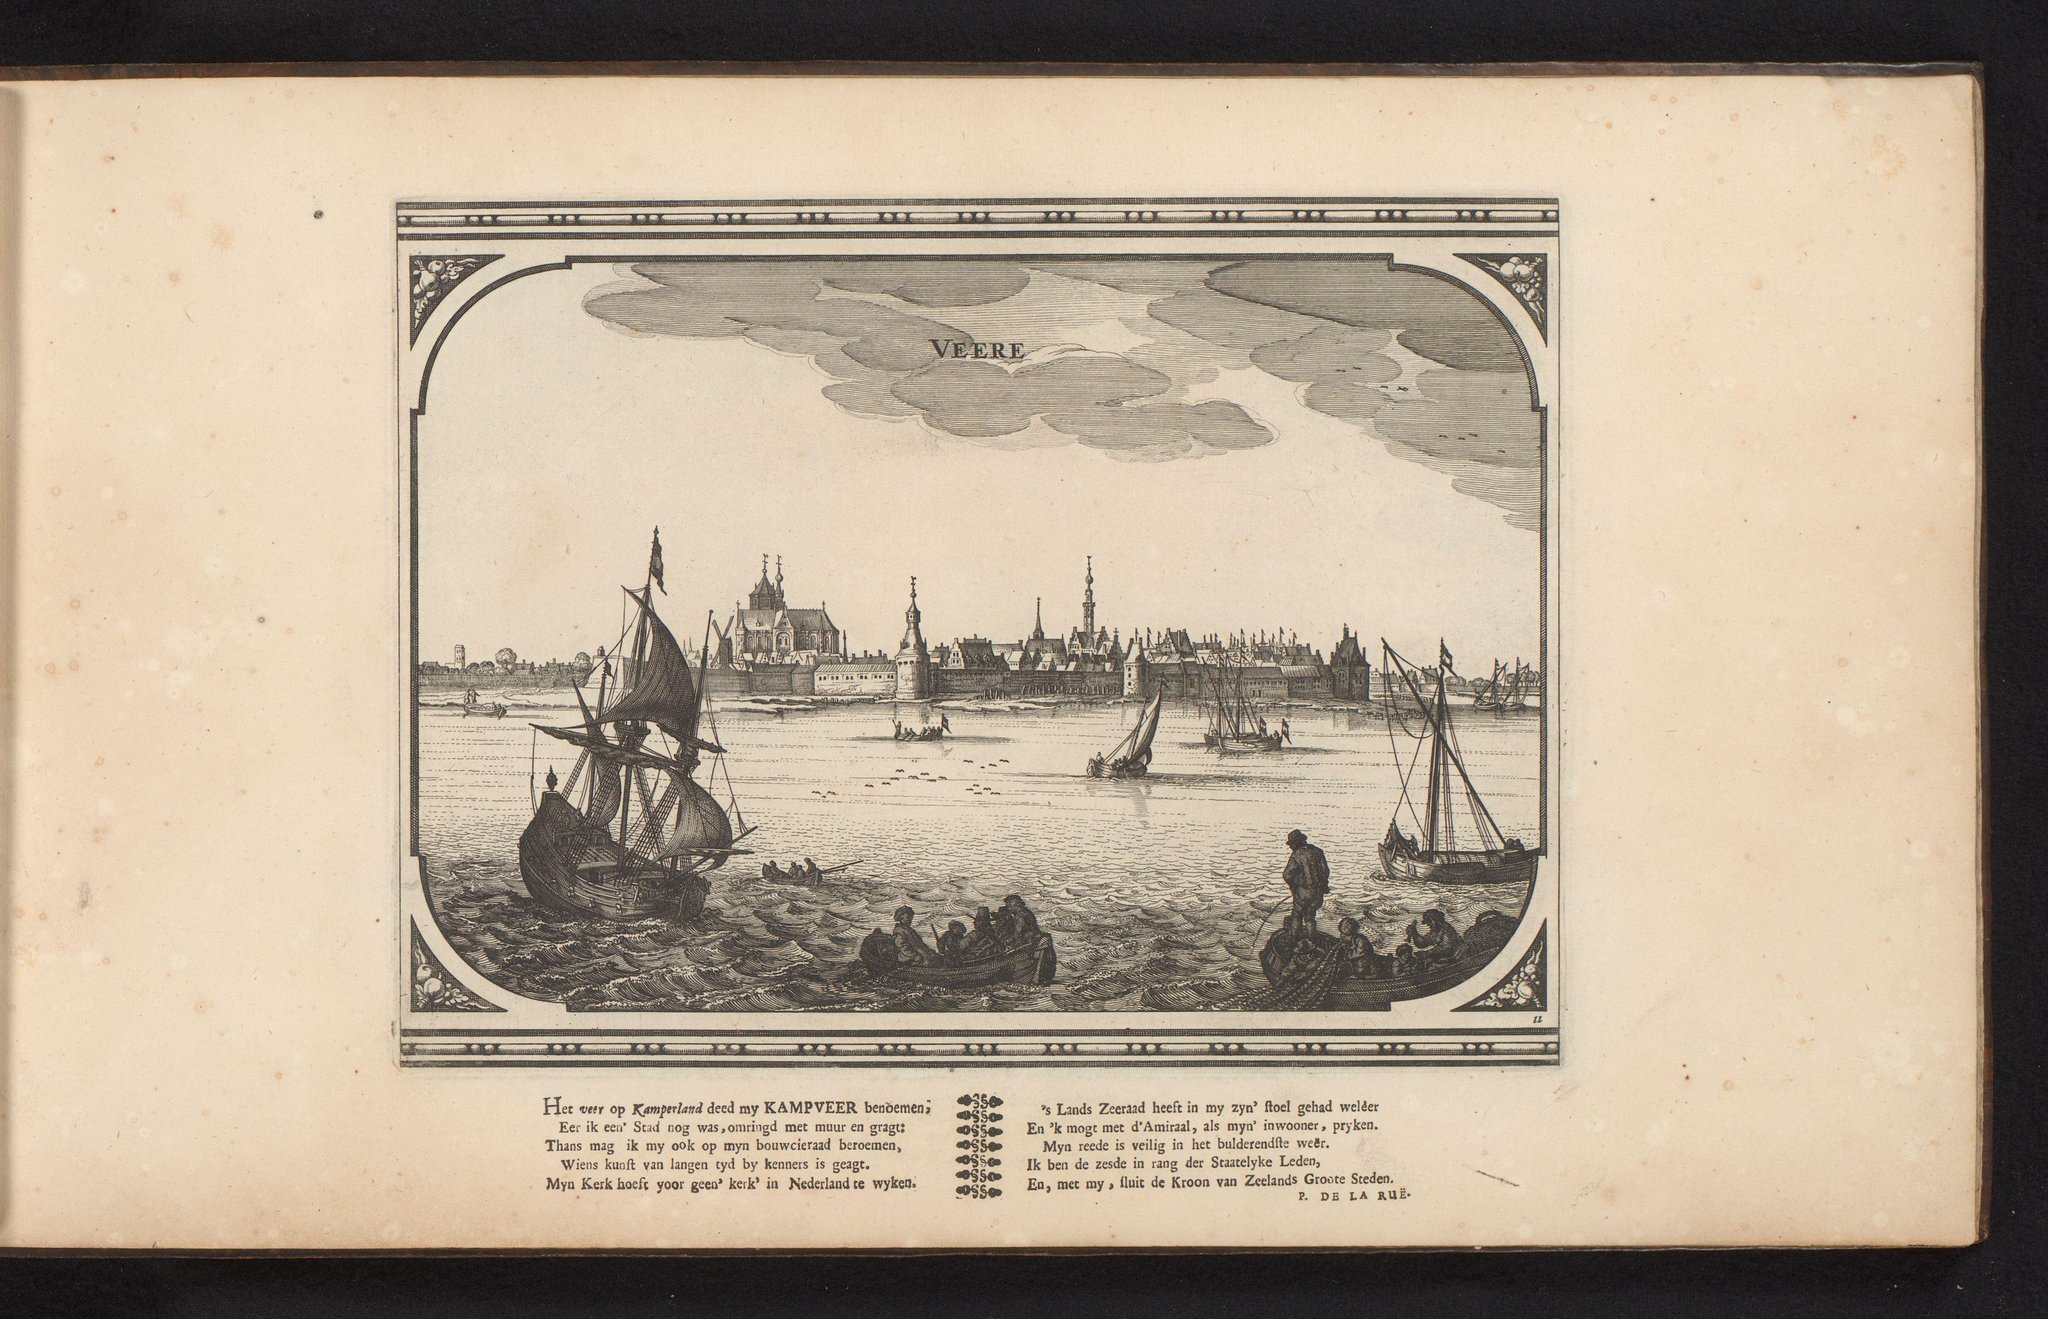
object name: print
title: Veere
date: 1731-1800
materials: paper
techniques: etching, letterpress printing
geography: middelburg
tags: city-view, and landscape with man-made constructions, river, urination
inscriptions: collector's mark: Lugt 195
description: Gezicht op de stad Veere, vanaf het Veerse meer. Op het meer varen verschillende boten. Rechts plast een man vanaf een boot in het water. Daaronder tien versregels in het Nederlands. De prent maakt deel uit van een album.